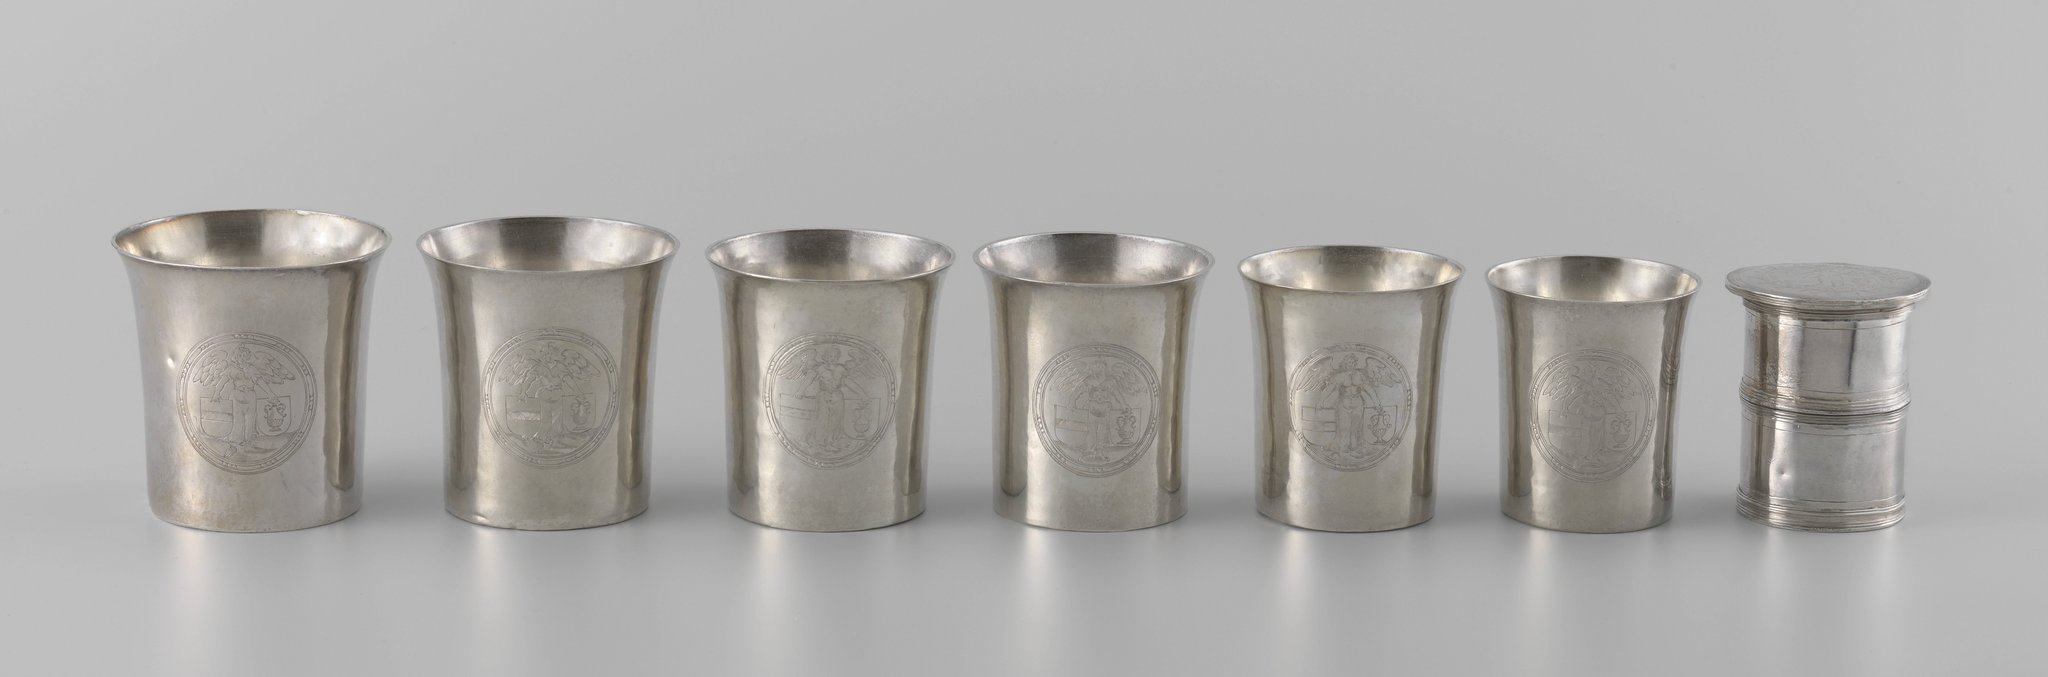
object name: kruidendoos, specerijdoos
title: Set van zes in elkaar passende bekers, een zoutvat en een specerijenvat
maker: Anonymous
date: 1600-1630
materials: silver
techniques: engraving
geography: flushing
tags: flushing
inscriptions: town mark, date letter: ‘G’, maker's mark, date letter: ‘R’, maker's mark, date letter: ‘N’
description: Nest of six cups with the arms of Flushing and Borselen. Silver. Flushing, c. 1600 - 1625, unknown masters.